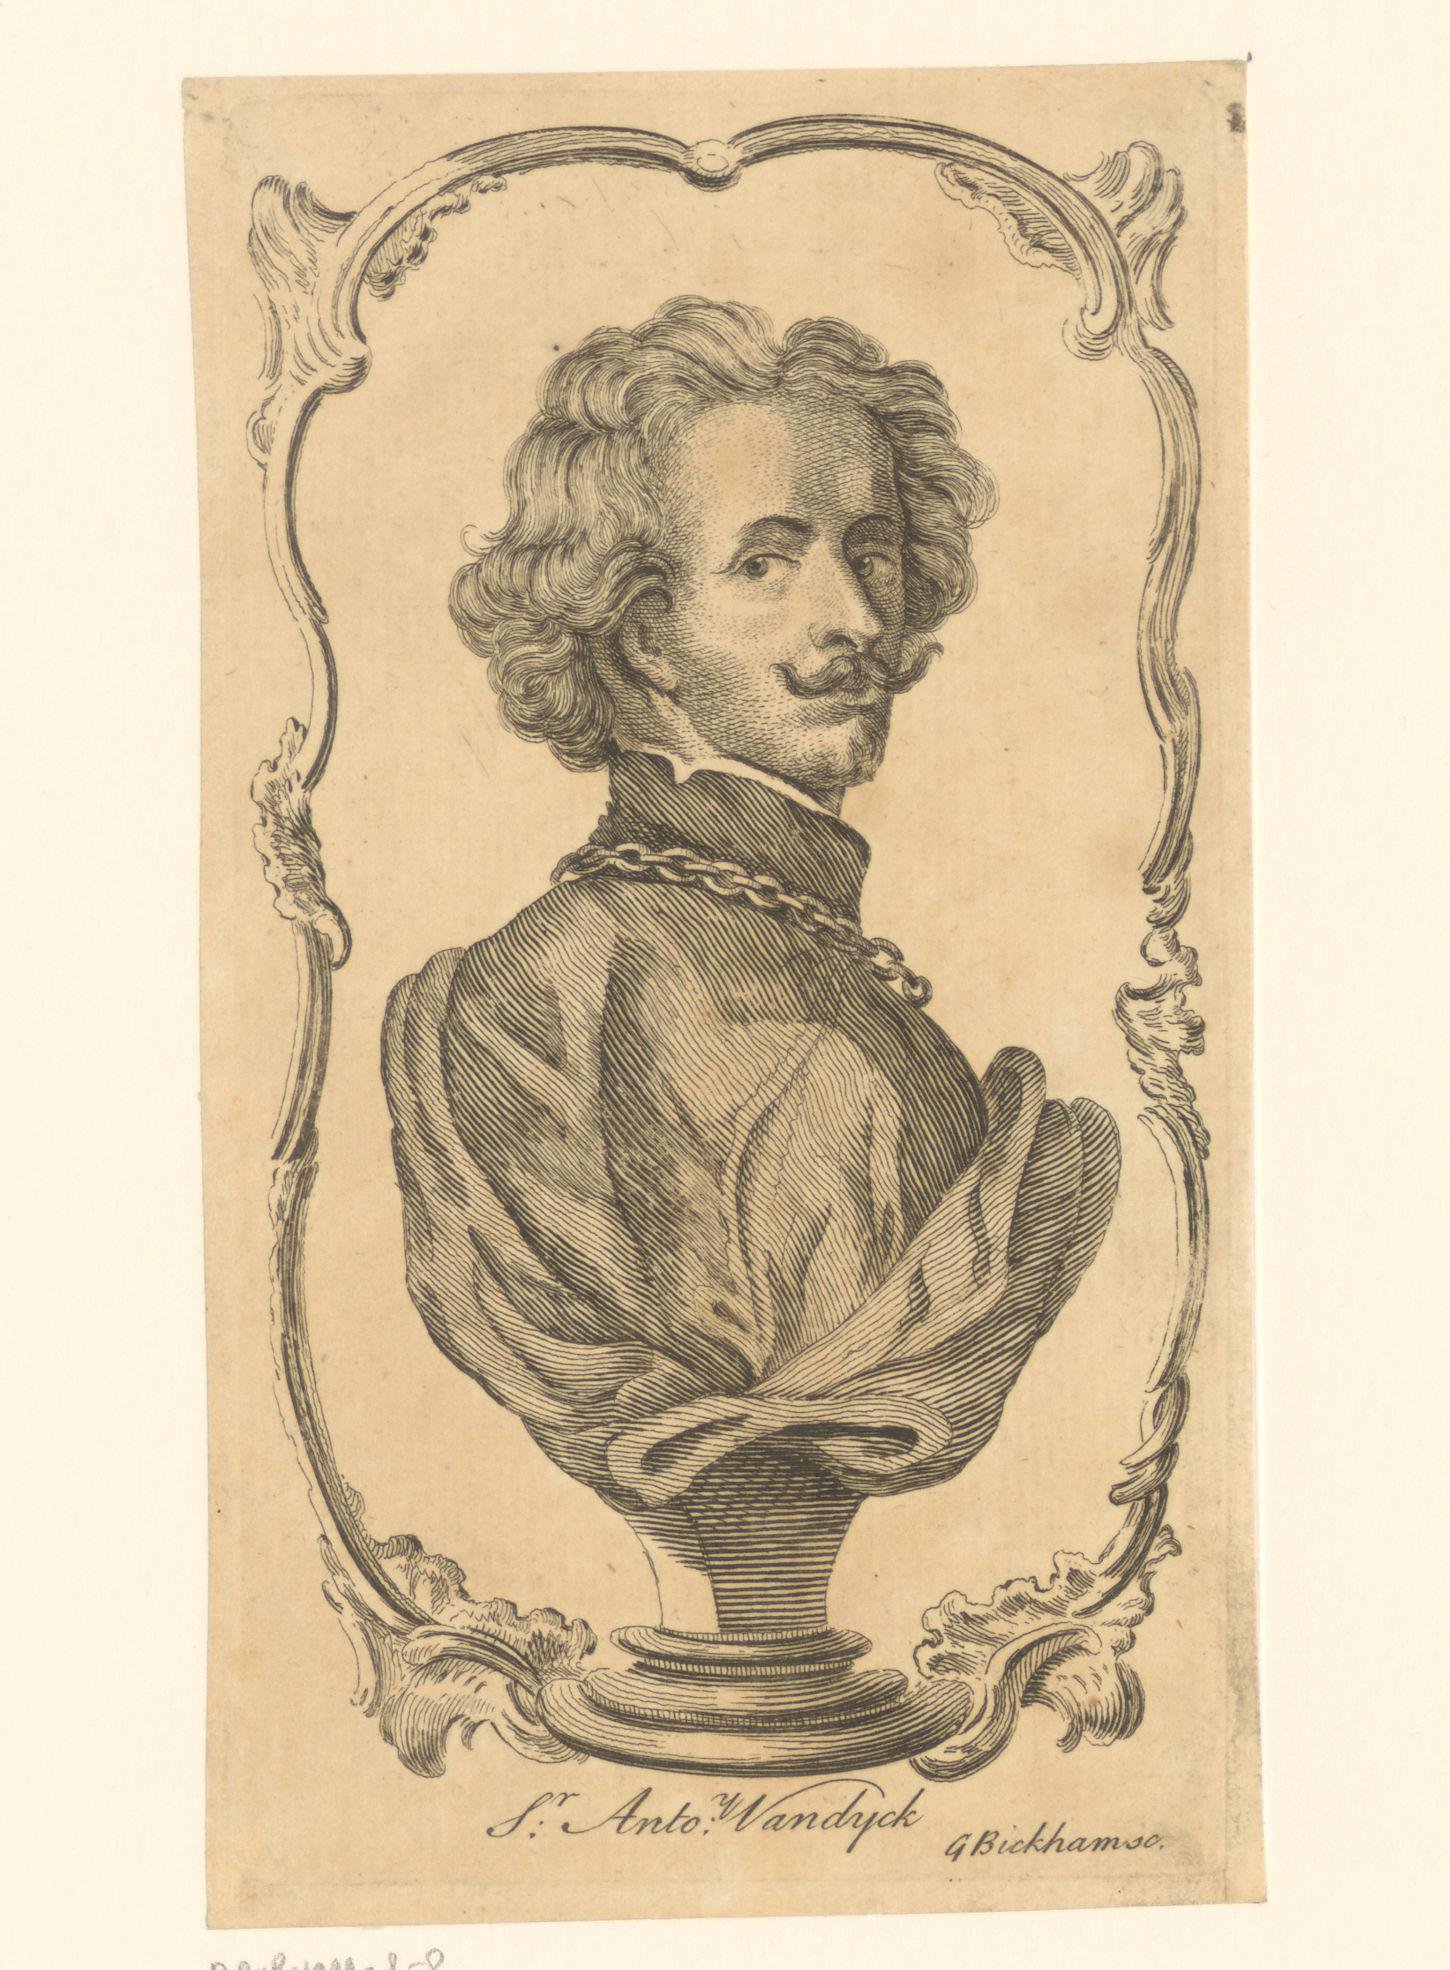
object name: print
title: Portret van Anthony van Dyck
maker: george bickham (ii)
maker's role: print maker, publisher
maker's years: 1706-1771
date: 1740-1771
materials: paper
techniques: etching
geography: england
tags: antwerp, london, painter, print maker, draughtsman, anthony van dyck, historical persons, portrait, self-portrait of painter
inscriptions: collector's mark: Lugt 2228, collector's mark: Lugt 2760